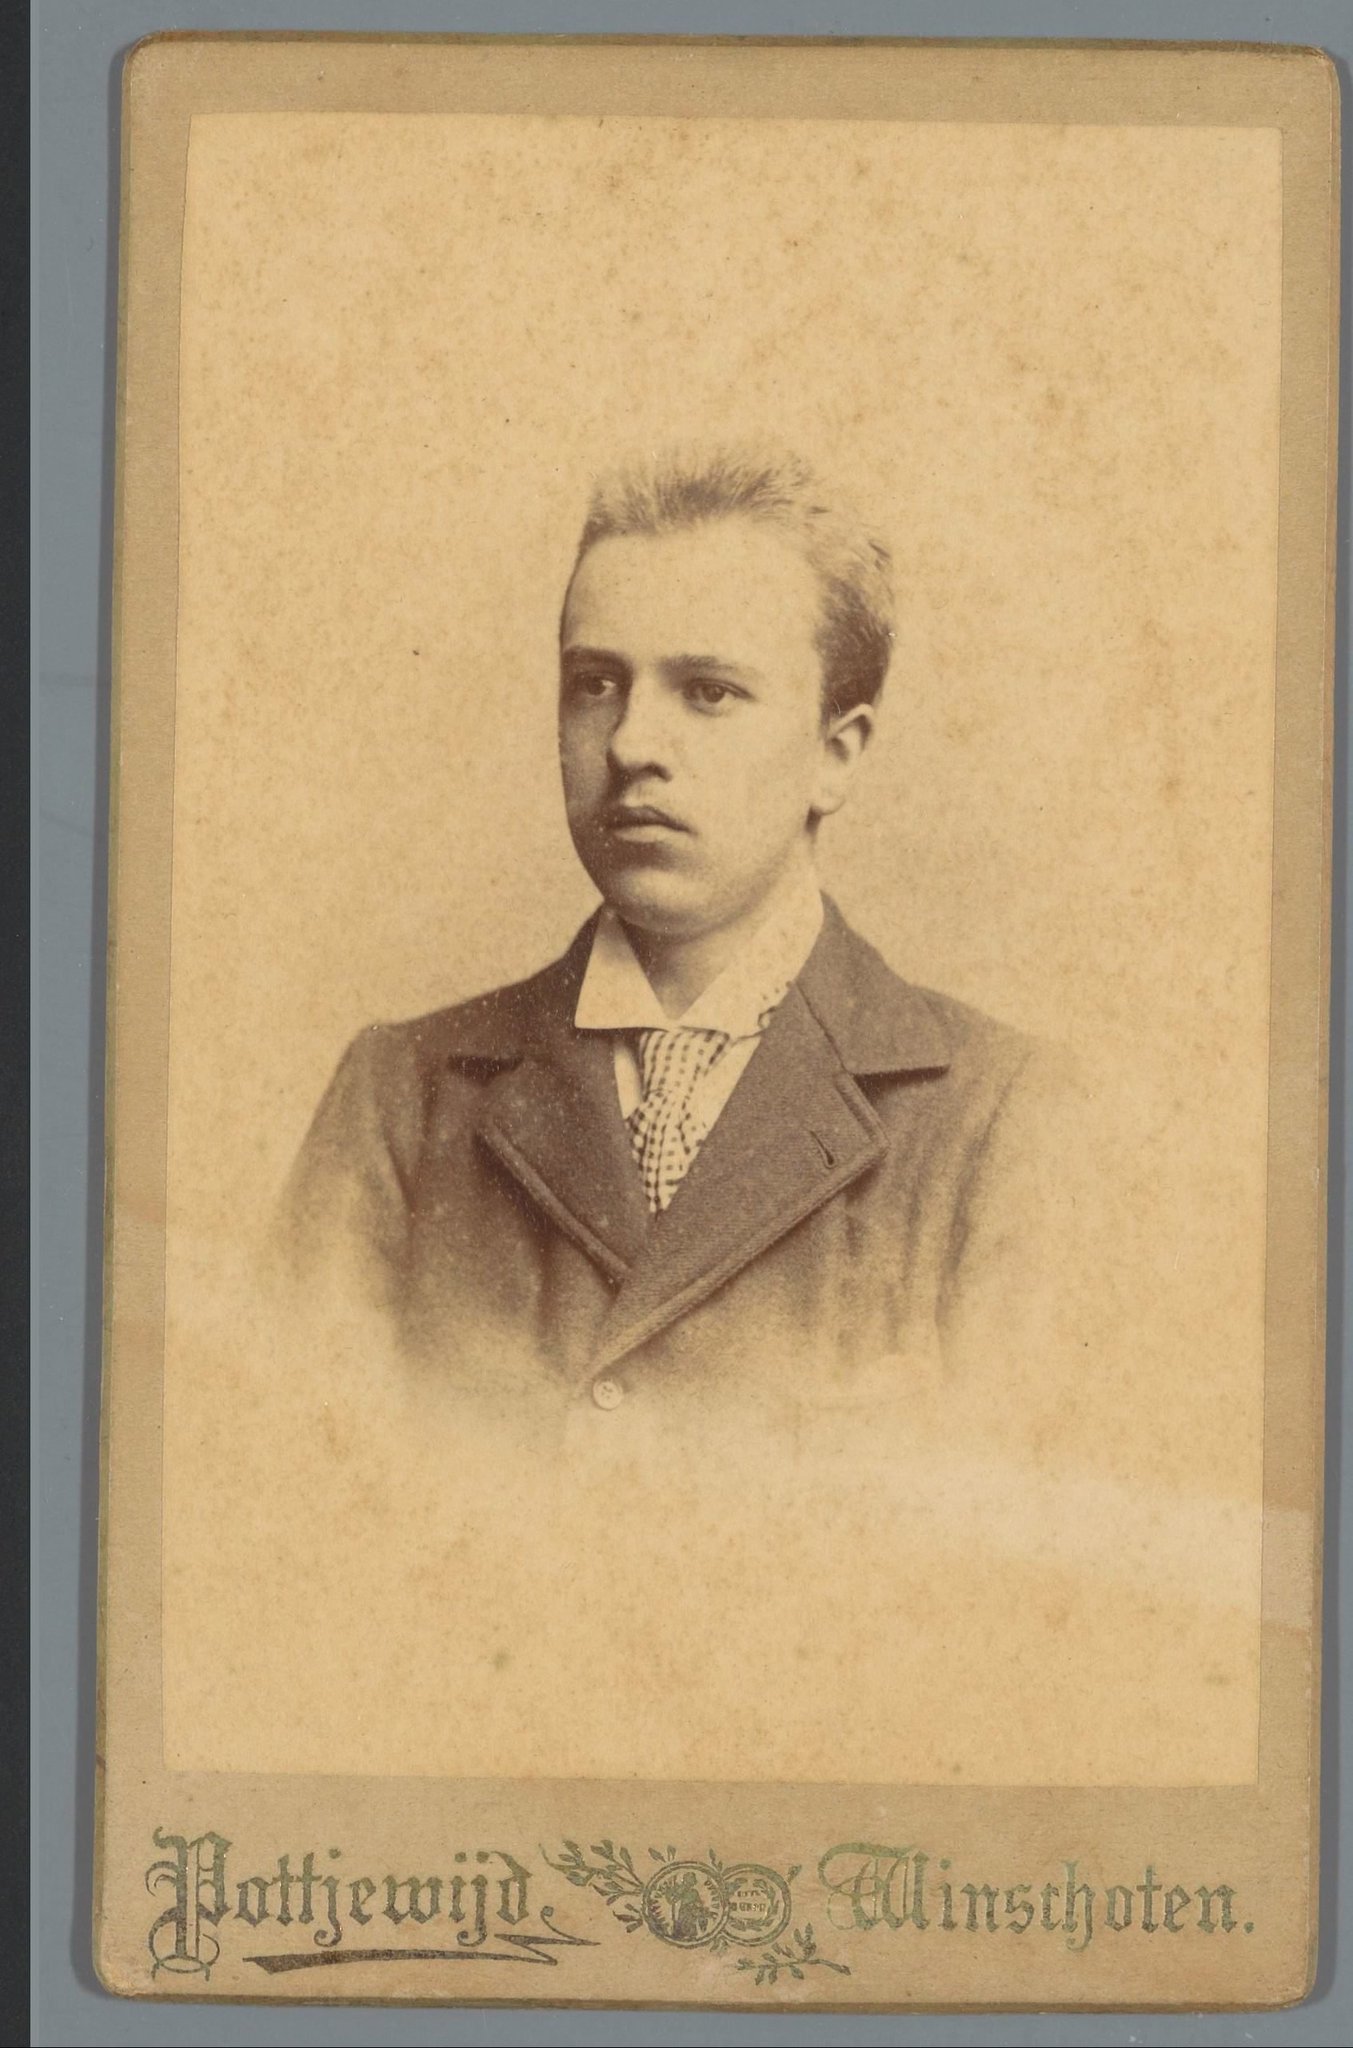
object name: photograph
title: Portret van een onbekende man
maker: b.j. pottjewijd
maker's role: fotograaf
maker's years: 1859-1941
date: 1880-1900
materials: cardboard, paper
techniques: albumen print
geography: winschoten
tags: adult man, historical persons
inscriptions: inscription: ‘B. J. Pottjewijd/ WINSCHOTEN/ Het negatief blijft voor nabestelling bewaard./ Vergrootingen in alle afmetingen./ BERNHARD WACHTL. WIEN.’